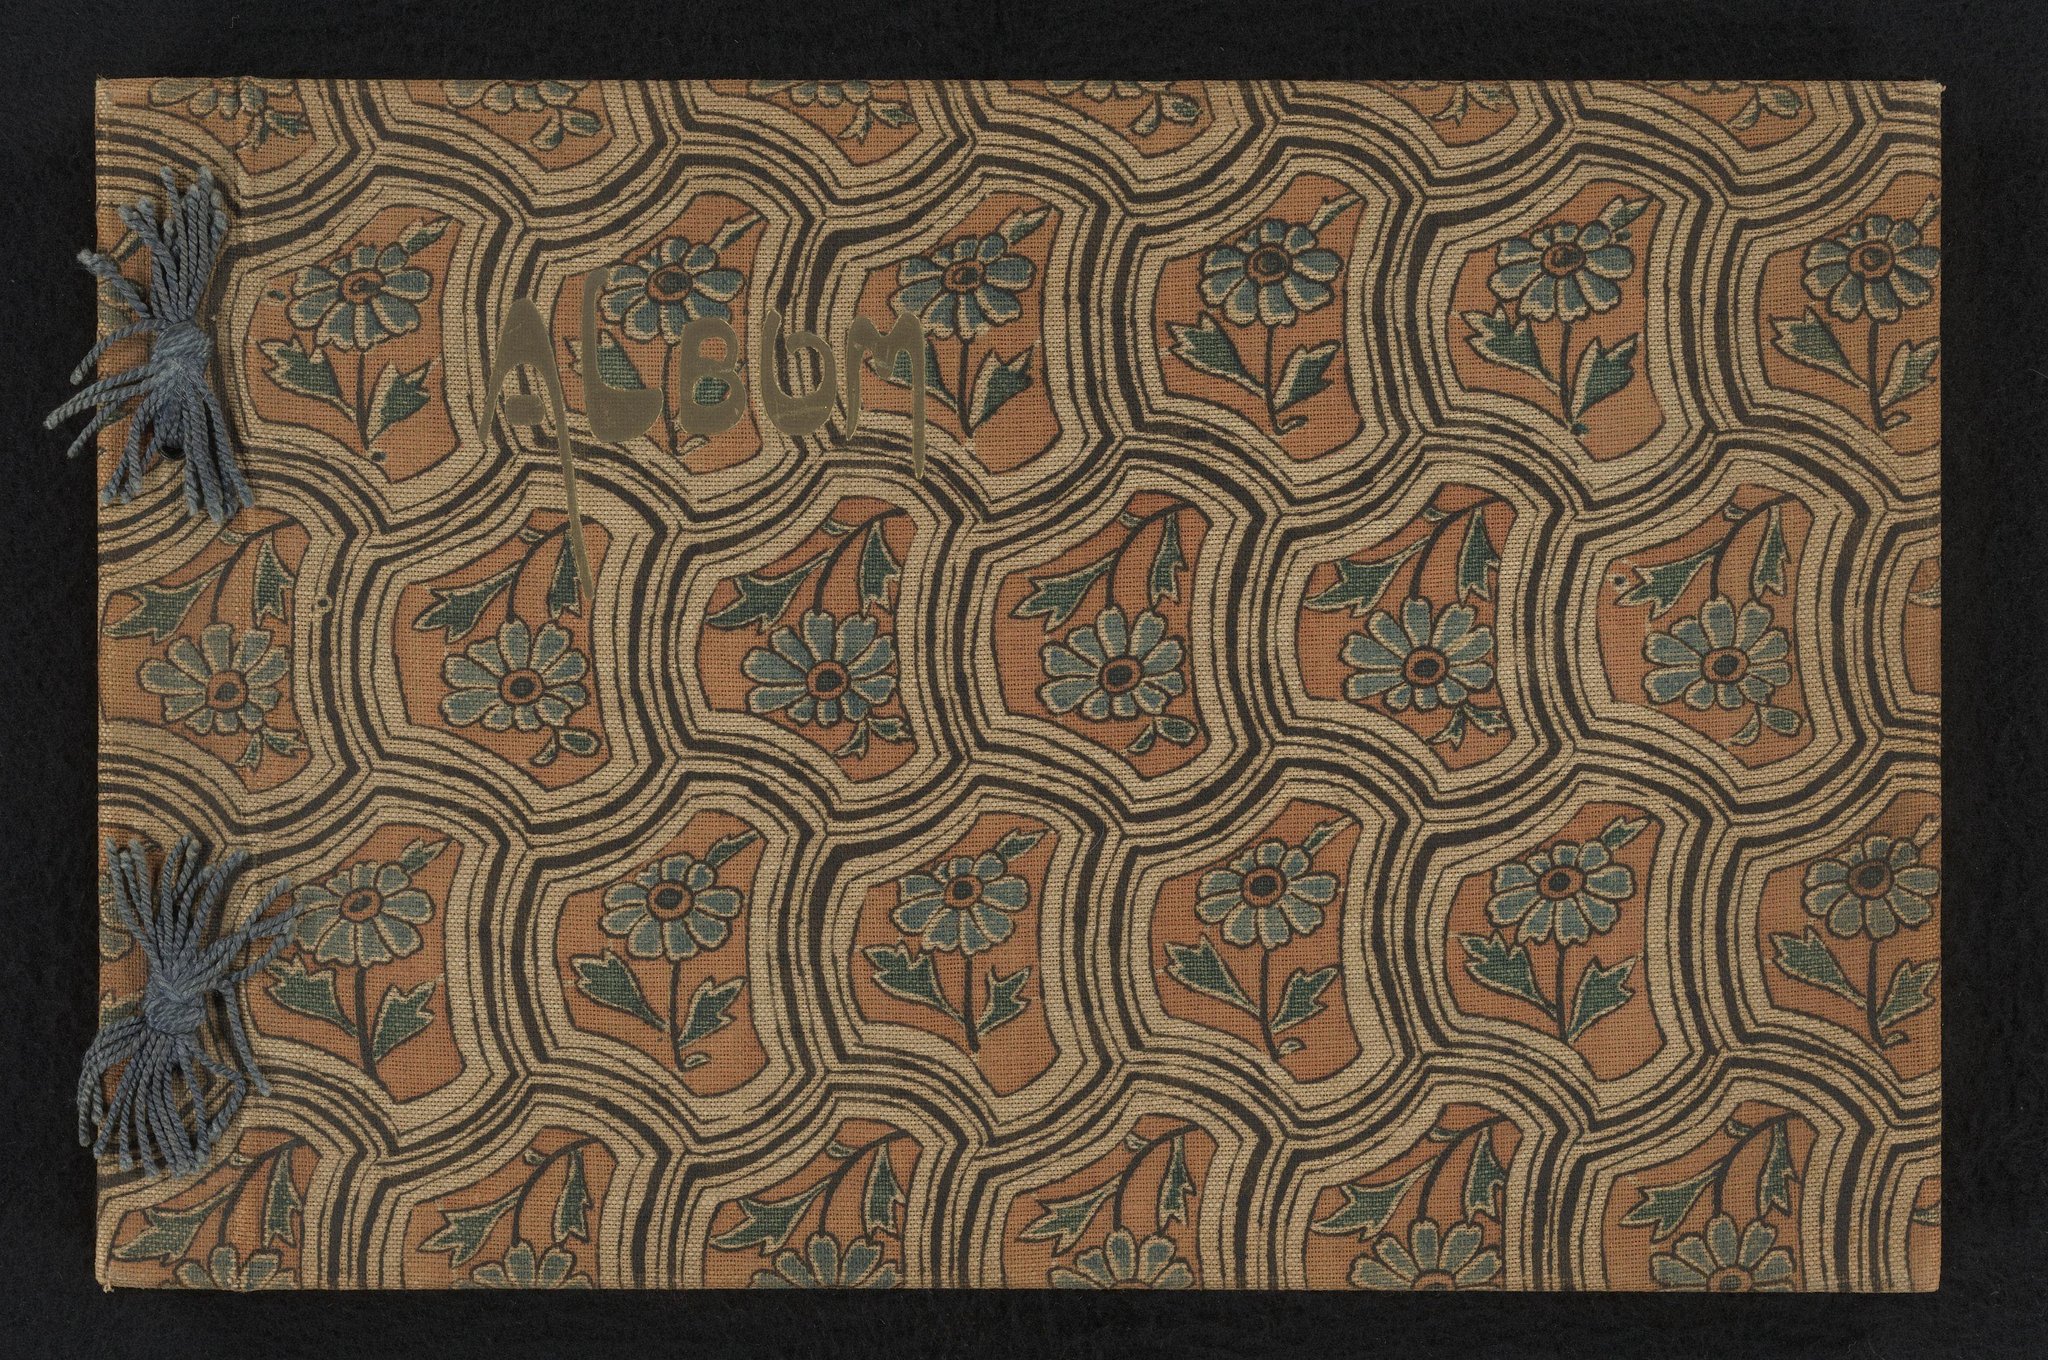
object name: photograph album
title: Reisalbum van Karel Frederik van den Berg met foto's uit Java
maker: karel frederik van den berg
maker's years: 1873-1948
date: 1921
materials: paper, cardboard, textile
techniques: gelatin silver print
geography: java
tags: amsterdam, norbert van den berg (1901-1972), batavia, karel frederik van den berg, willem jacob van den berg, caroline frederique van den berg, arendina charlotte marie van den berg-geertsema, family life, 'en route', traveller under way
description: Reisalbum van Karel Frederik van den Berg met 54 foto's op 24 bladen en negen losse foto's, uit Java.